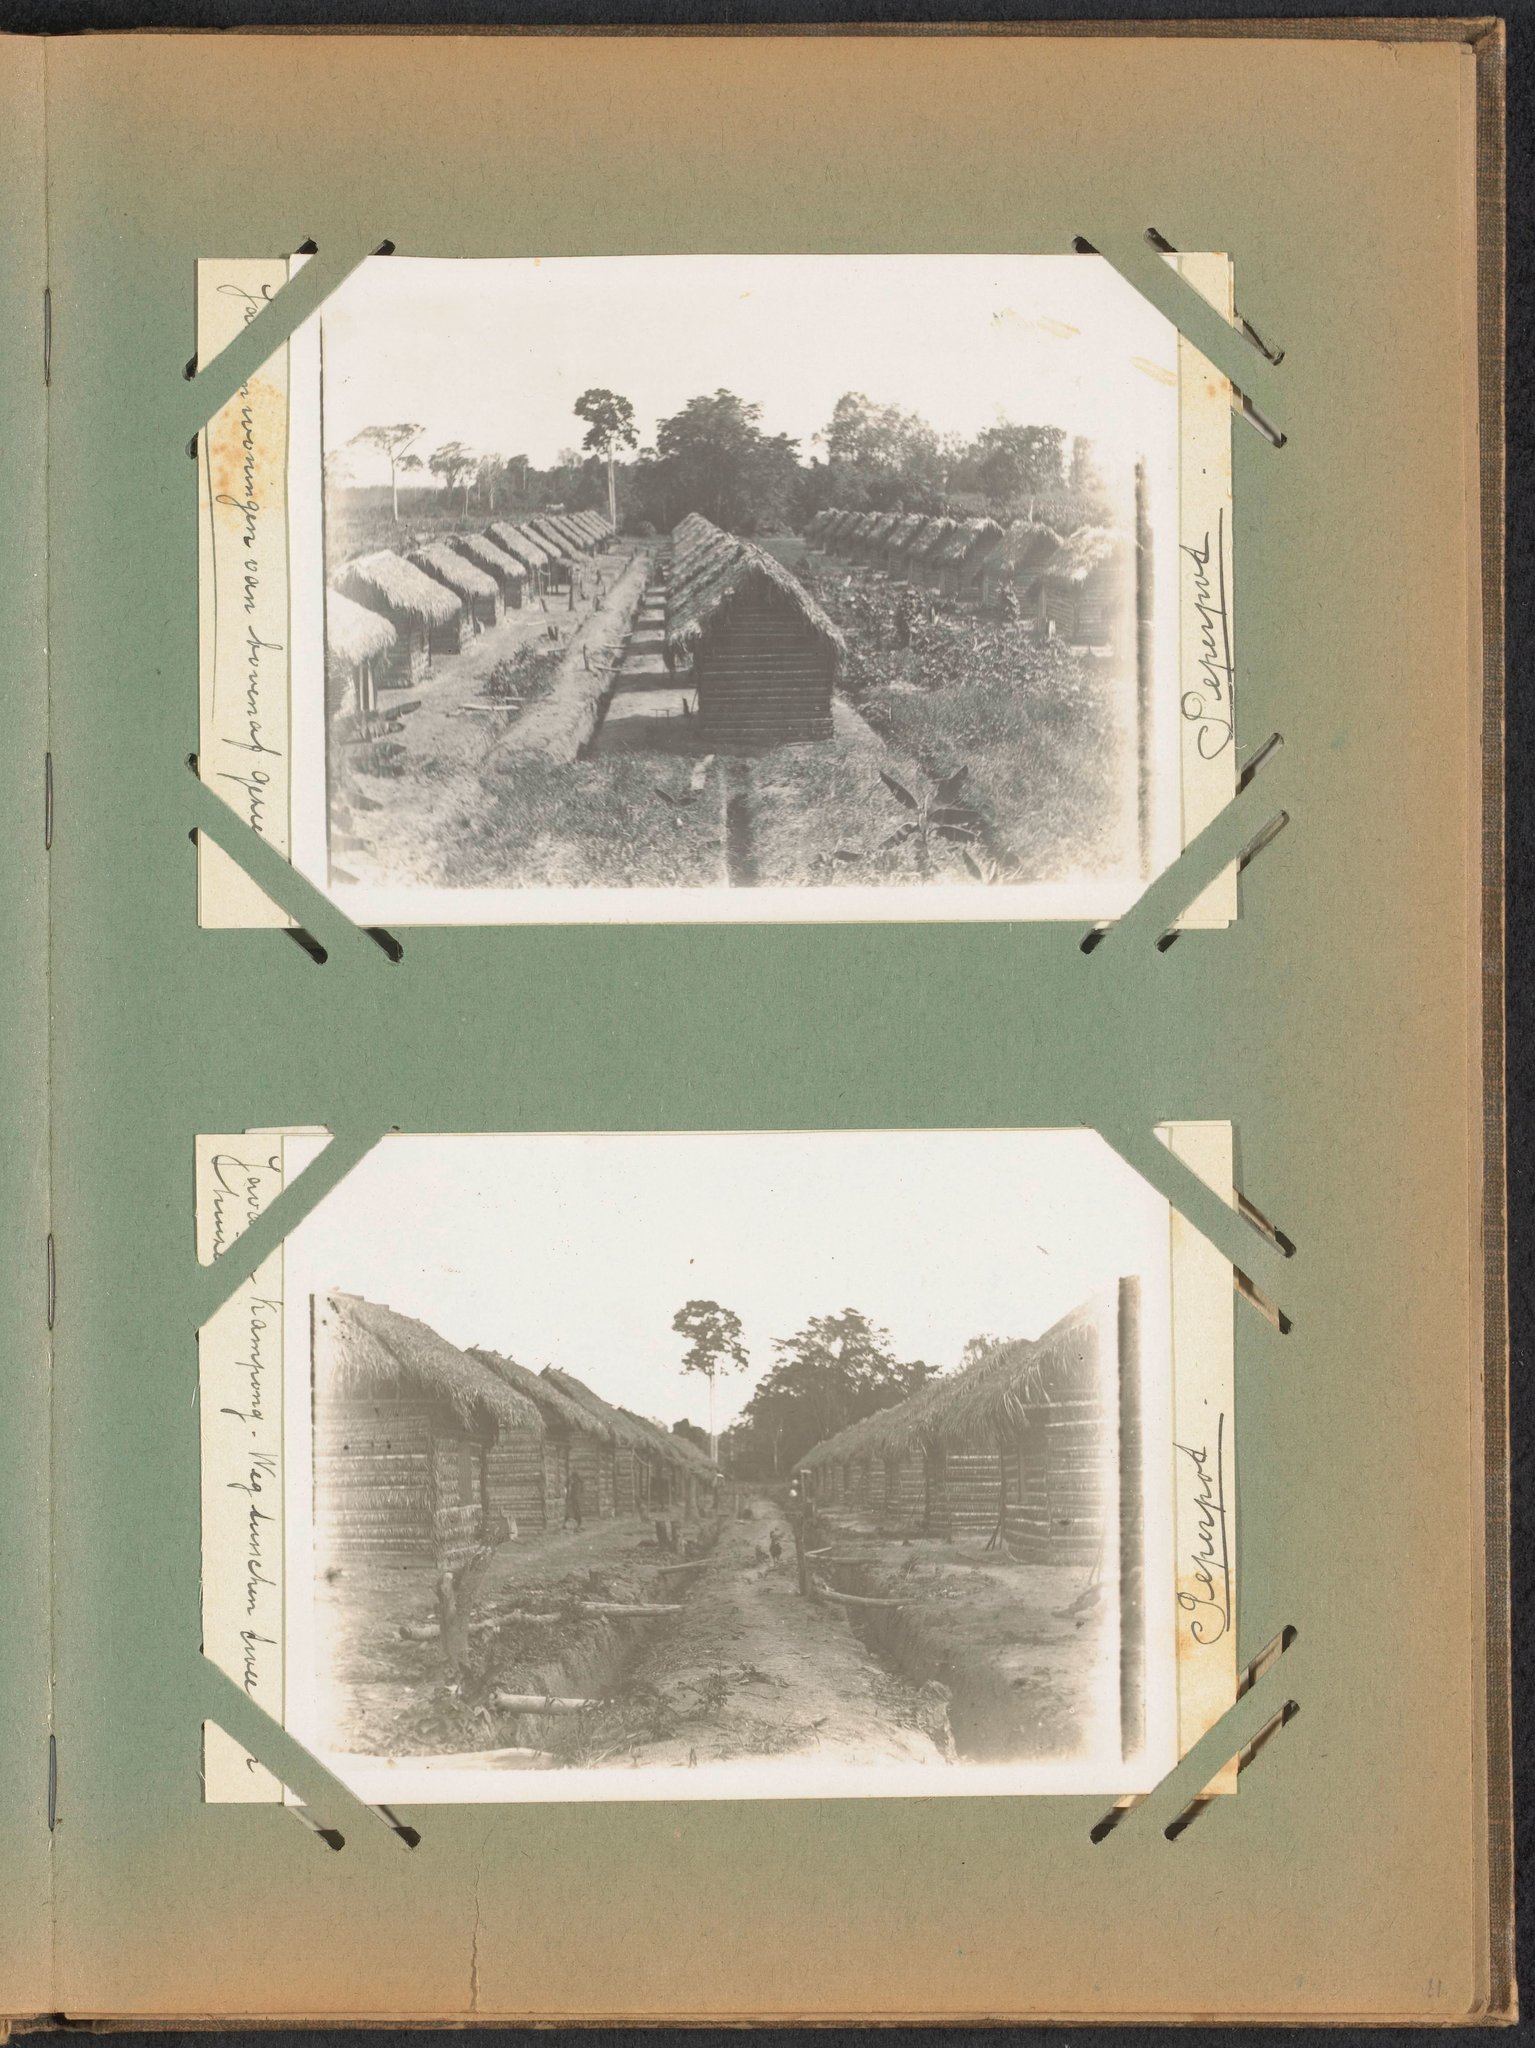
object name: photograph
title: Woningen van de Javaanse werknemers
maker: Anonymous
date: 1912-1913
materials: paper, photographic support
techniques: gelatin silver print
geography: suriname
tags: plantation, working class, labourers, suriname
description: Gezicht tussen de rijen woningen van de Javaanse werknemers op Plantage Peperpot in Suriname. Onderdeel van het fotoalbum uit ca. 1912-1913 met 92 foto's van de plantages Peperpot en Dordrecht in Suriname en Mount Pleasant op Curaçao.